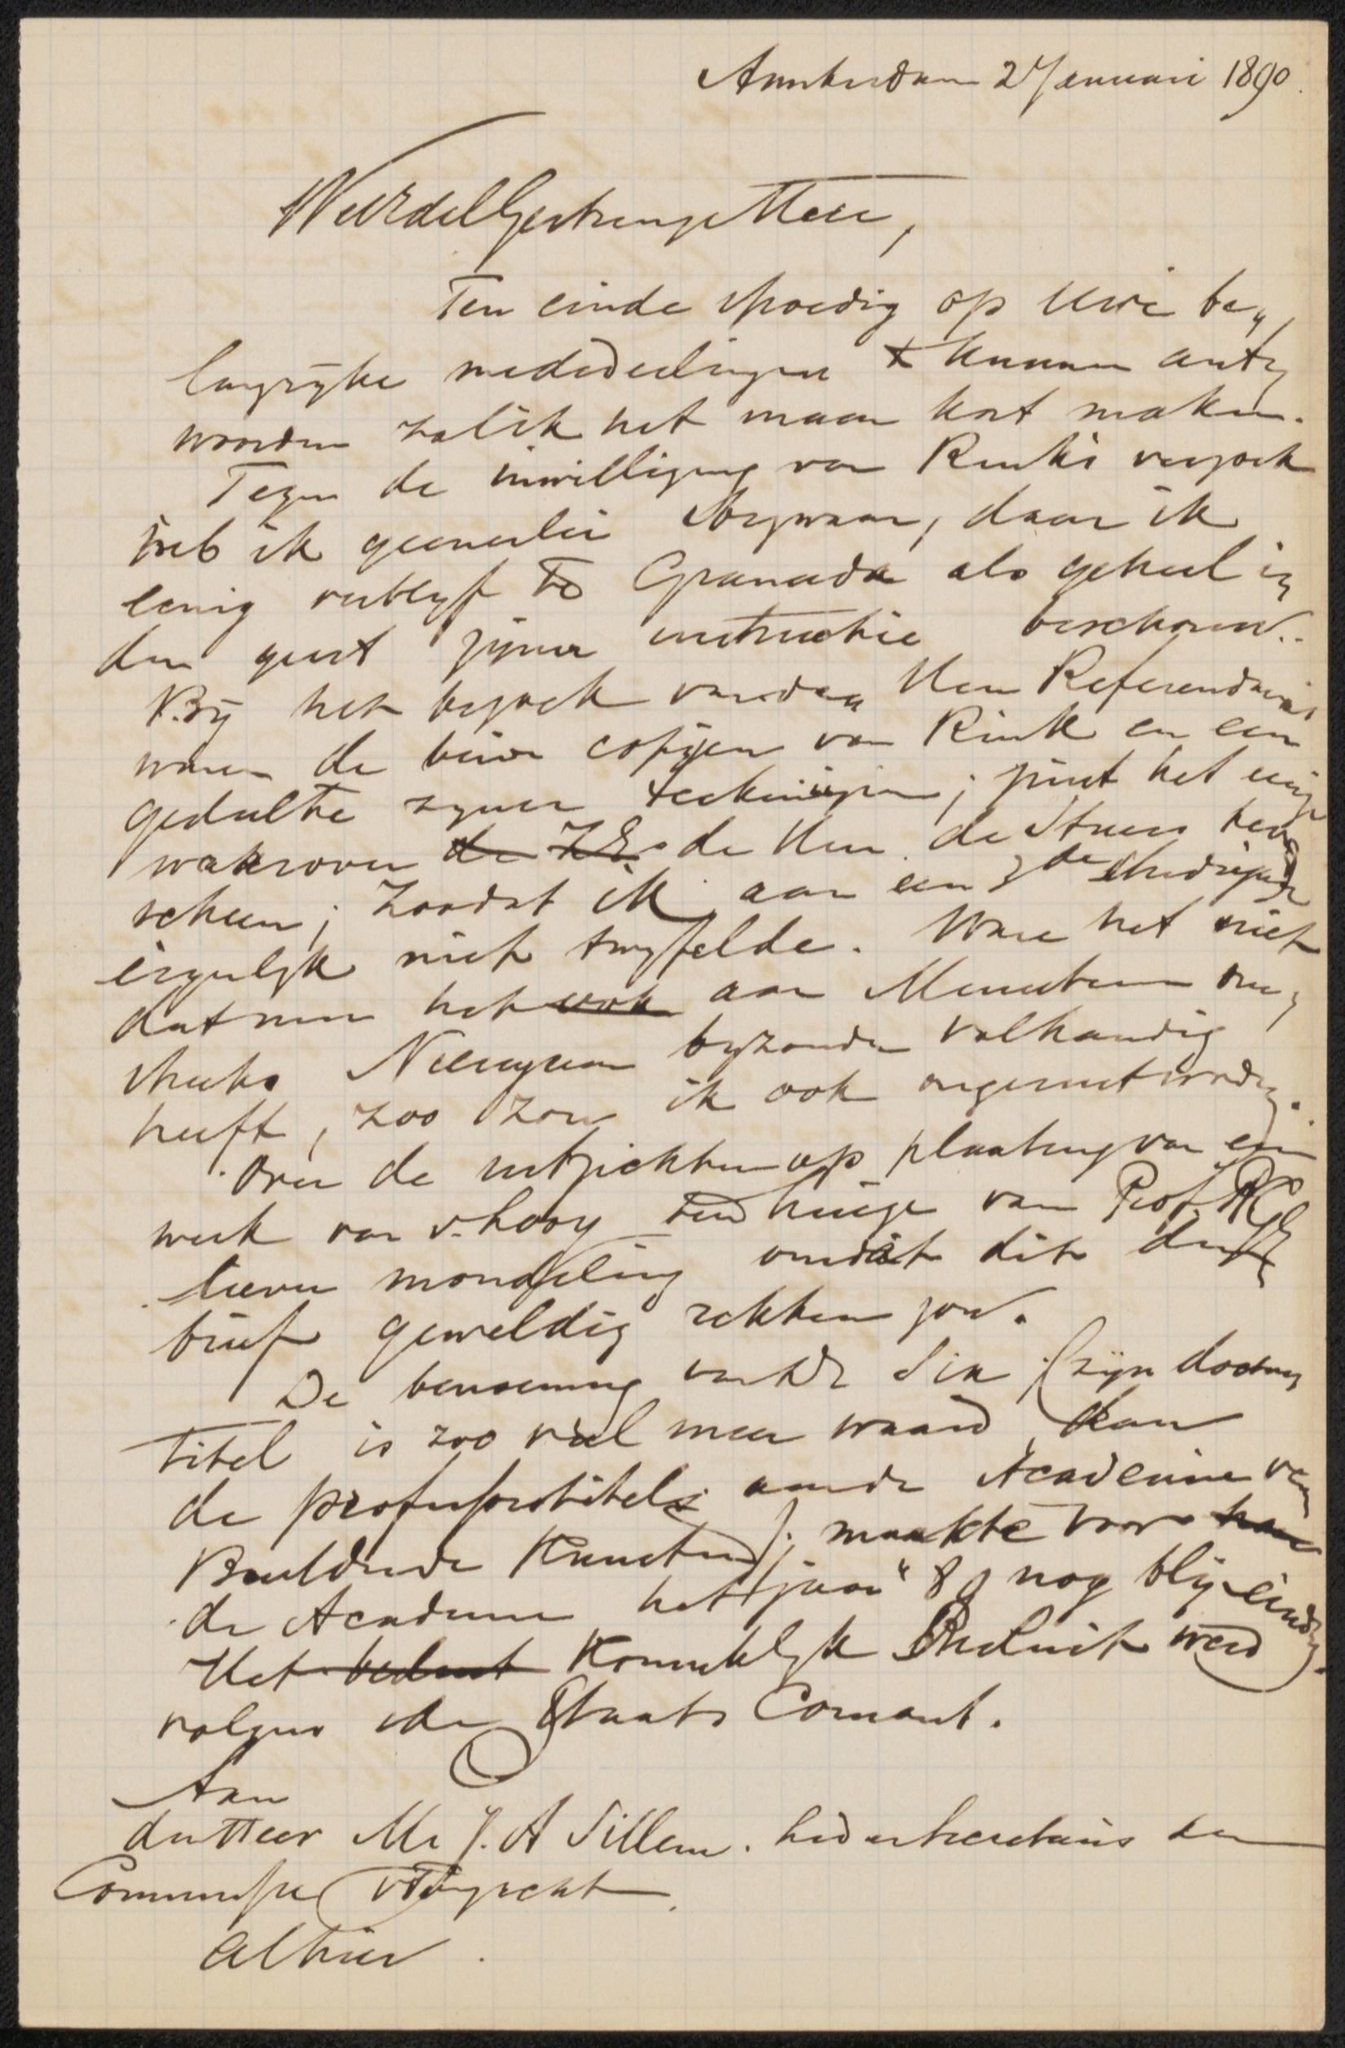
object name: letter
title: Brief aan Jérôme Alexander Sillem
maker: august allebé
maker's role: draughtsman, print maker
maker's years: 1838-1927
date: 1890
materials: ink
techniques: pen, writing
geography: amsterdam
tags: maastricht, jonkheer victor eugène louis de stuers, haarlem, painter, print maker, draughtsman, jac van looij, veghel, paul rink, jonkheer jan six, politician, jérôme alexander sillem, drawing, travelling; tourism, education, tuition of the artist (in general)